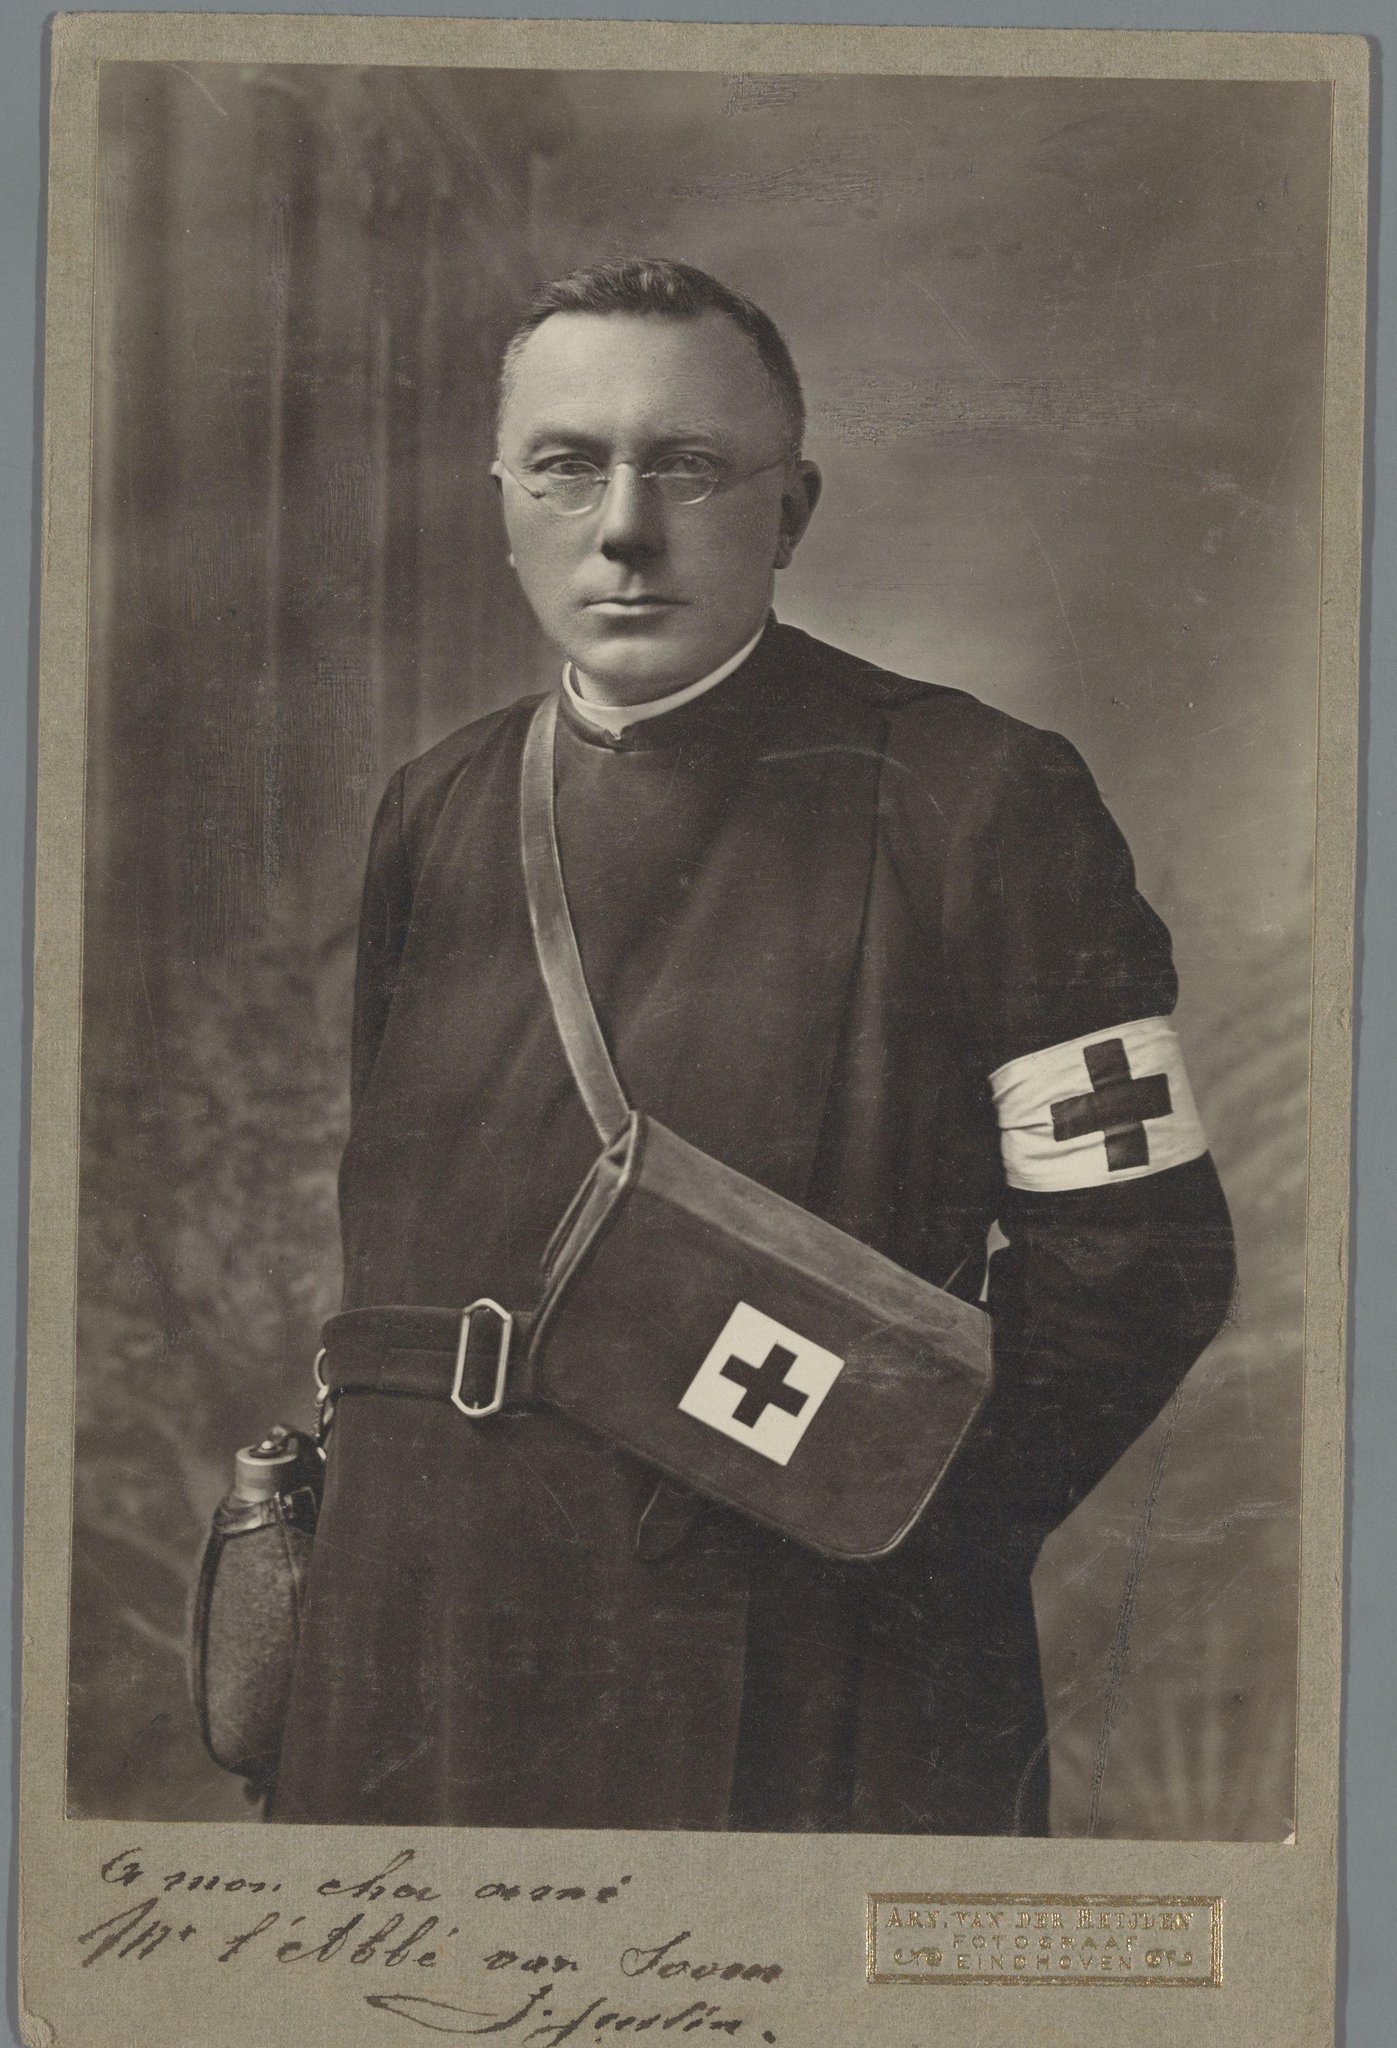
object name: cabinet photograph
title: Portret van vermoedelijk een geestelijke met een embleem van rode kruis op zijn mouw en tas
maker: arn. van der heijden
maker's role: fotograaf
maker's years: 1894-1966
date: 1914-1920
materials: cardboard, photographic support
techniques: gelatin silver print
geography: eindhoven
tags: adult man, organization, functionaries and dignitaries in roman catholic church; clergy in general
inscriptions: inscription: ‘En Moi, choi [...]né [...]’